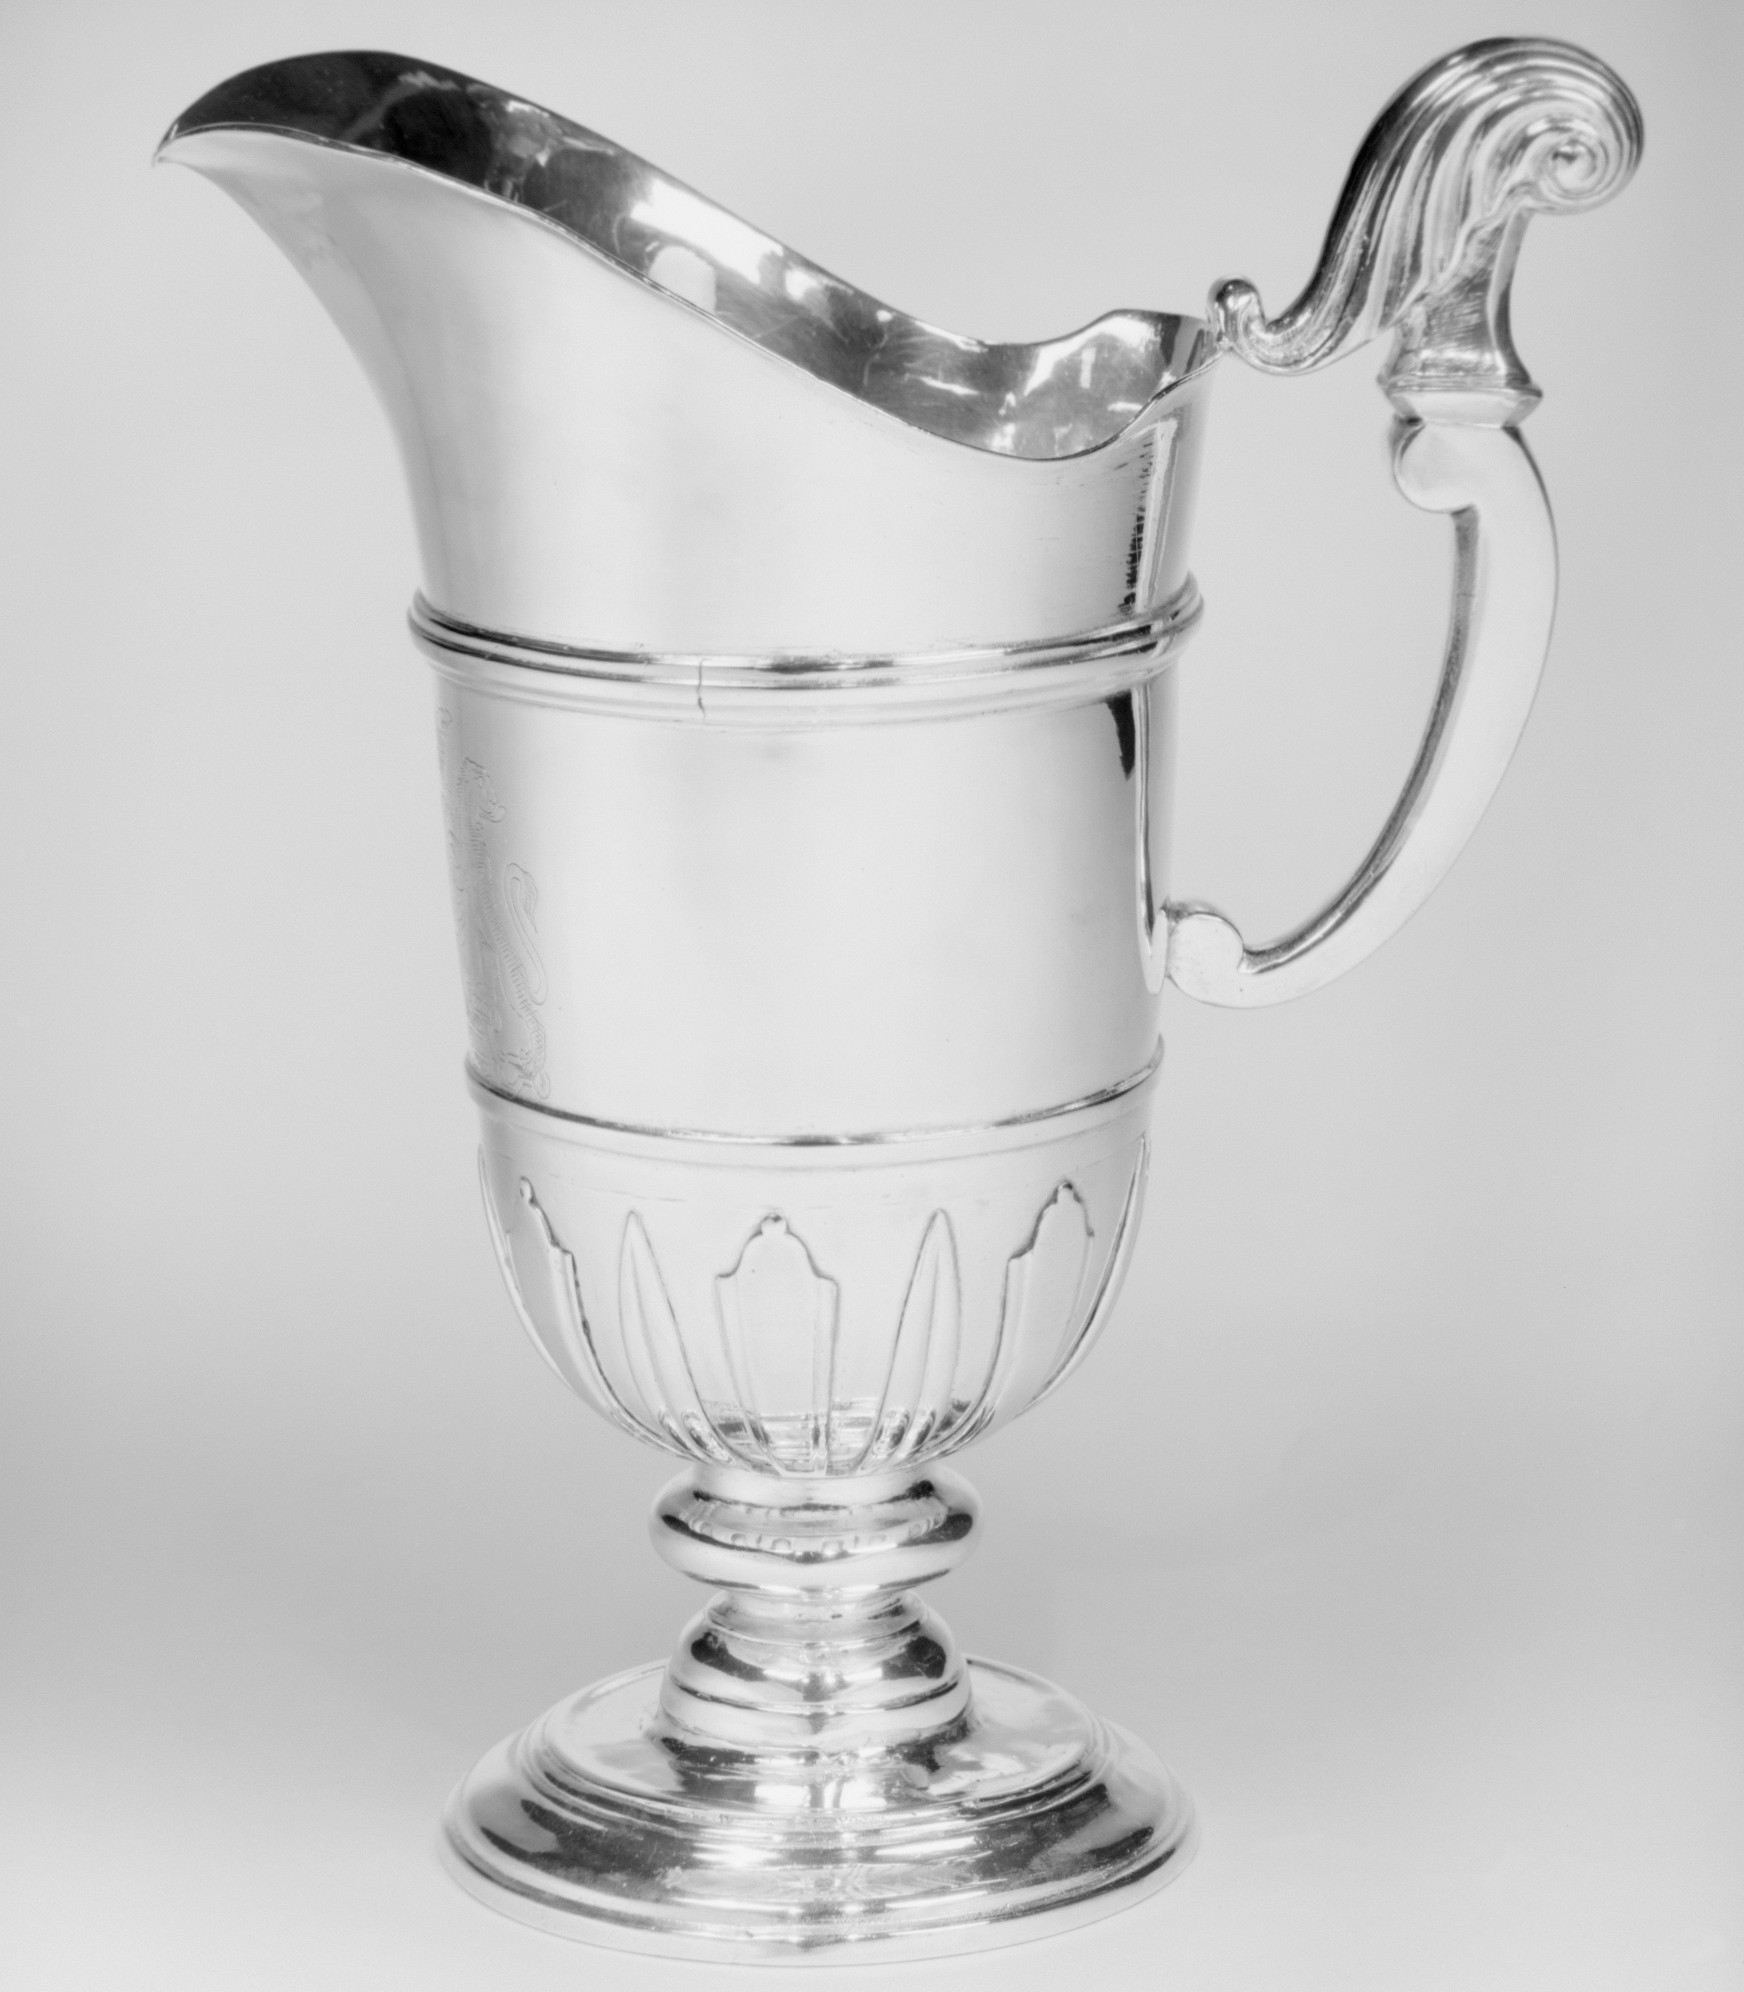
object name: ewer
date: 1700-1720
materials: brass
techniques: silvered